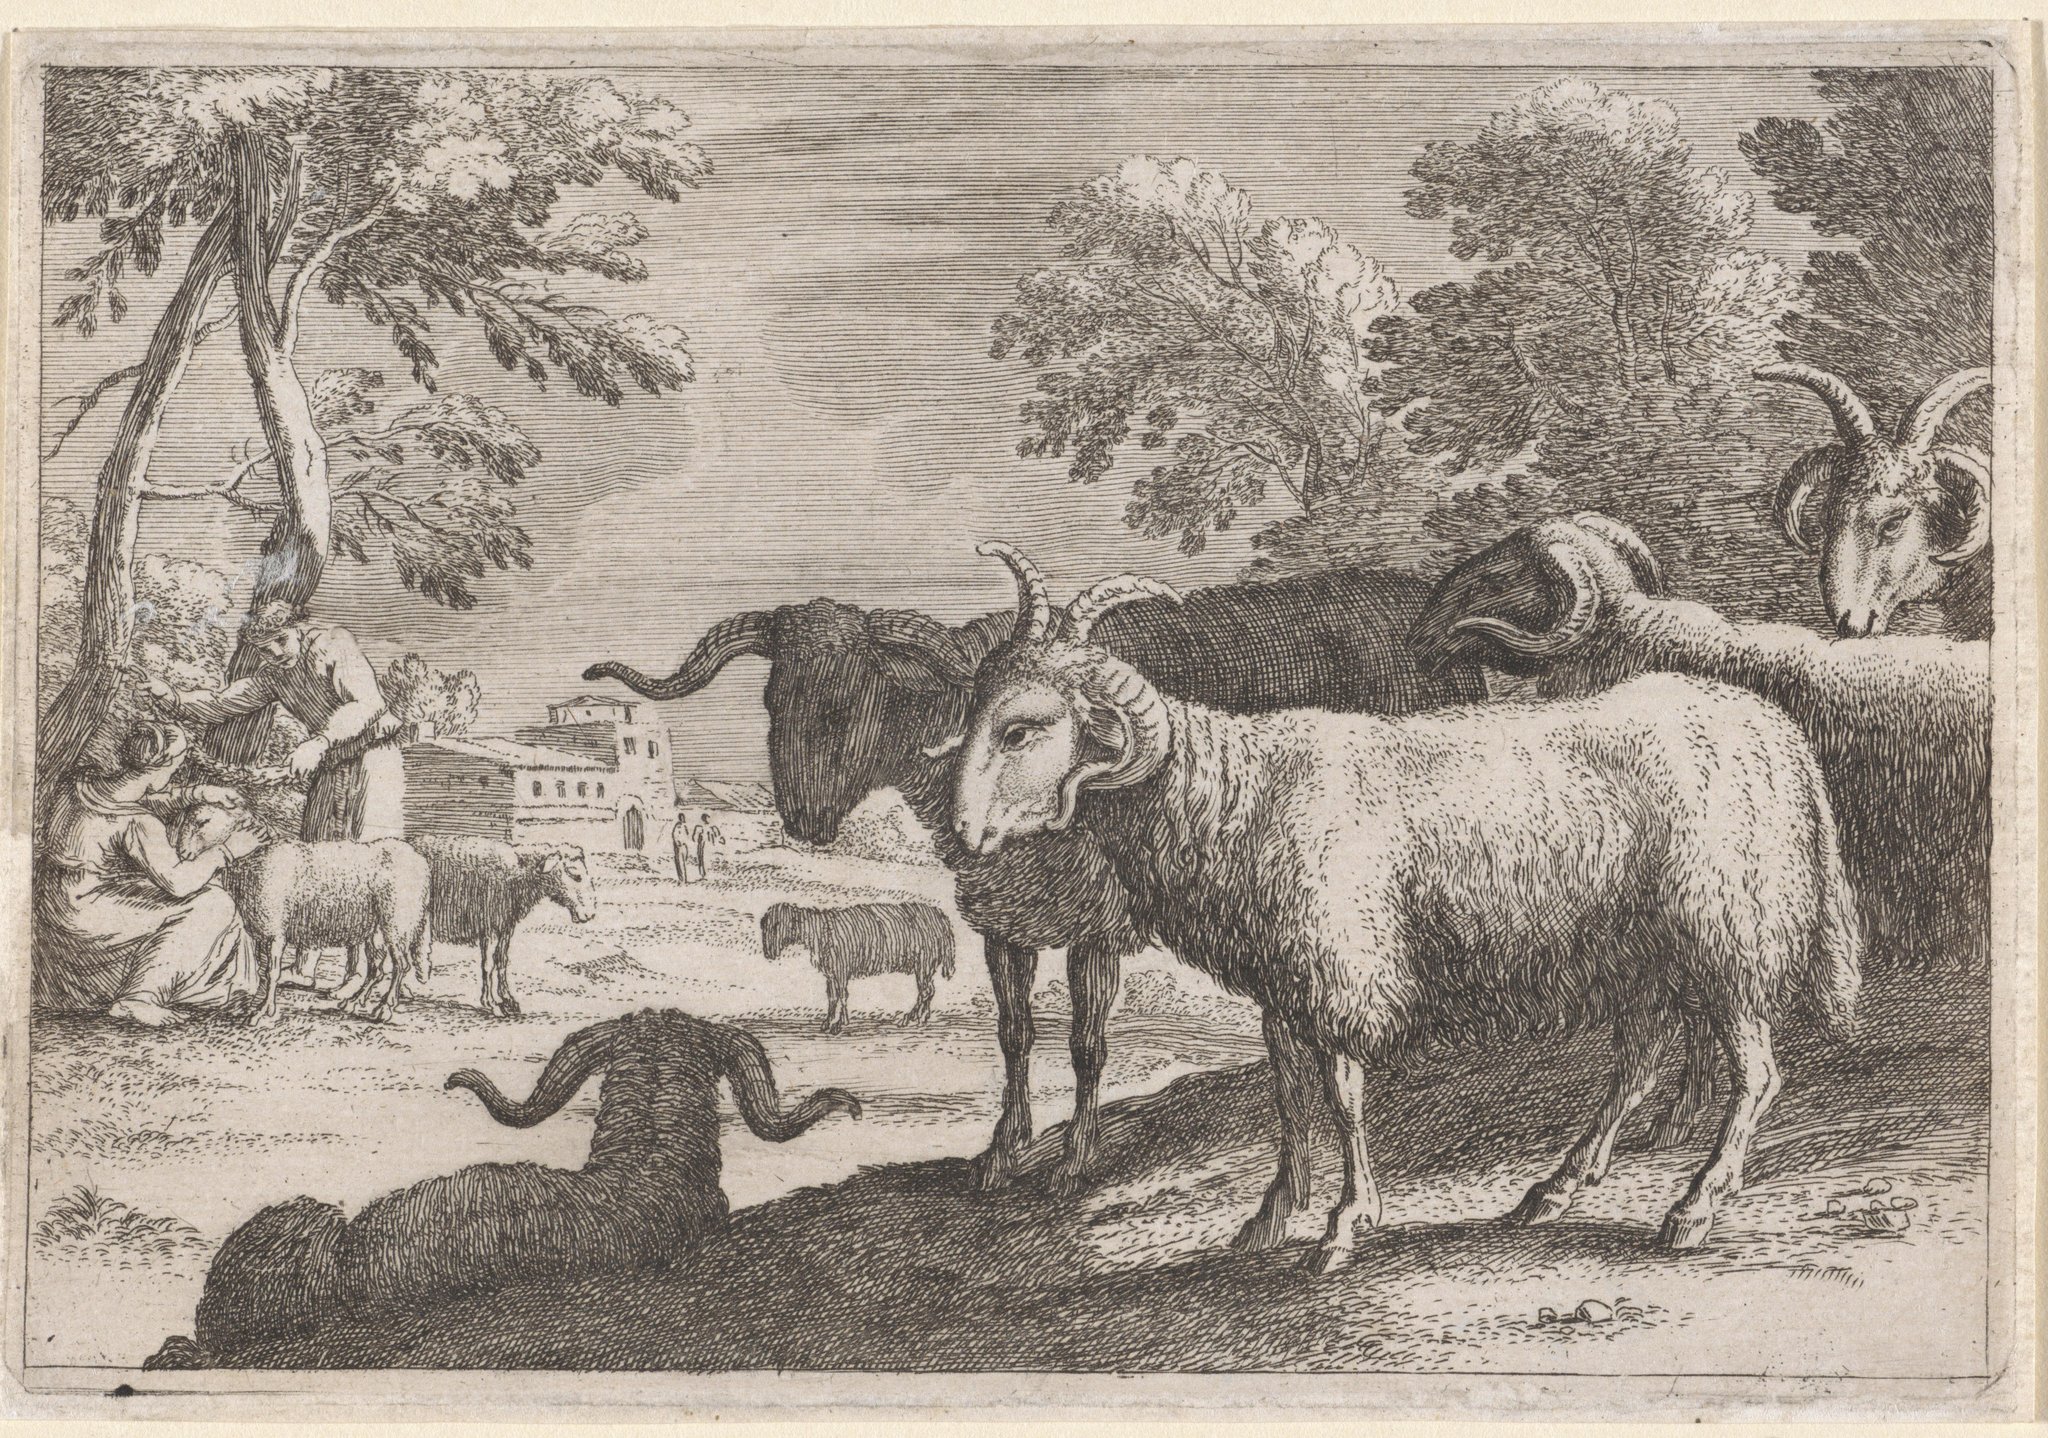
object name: print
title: Landschappen met dieren (serie A)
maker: Anonymous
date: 1636-1705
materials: paper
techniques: etching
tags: solomon expels abiathar from the priesthood and banishes him to anathoth, landscapes, ram, rural housing, e.g. country-house, villa, cottage, herd, flock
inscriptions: collector's mark: Lugt 2228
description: Achter vijf rammen zijn een herder en herderin met een kudde schapen te zien. In de verte ligt een gebouw.